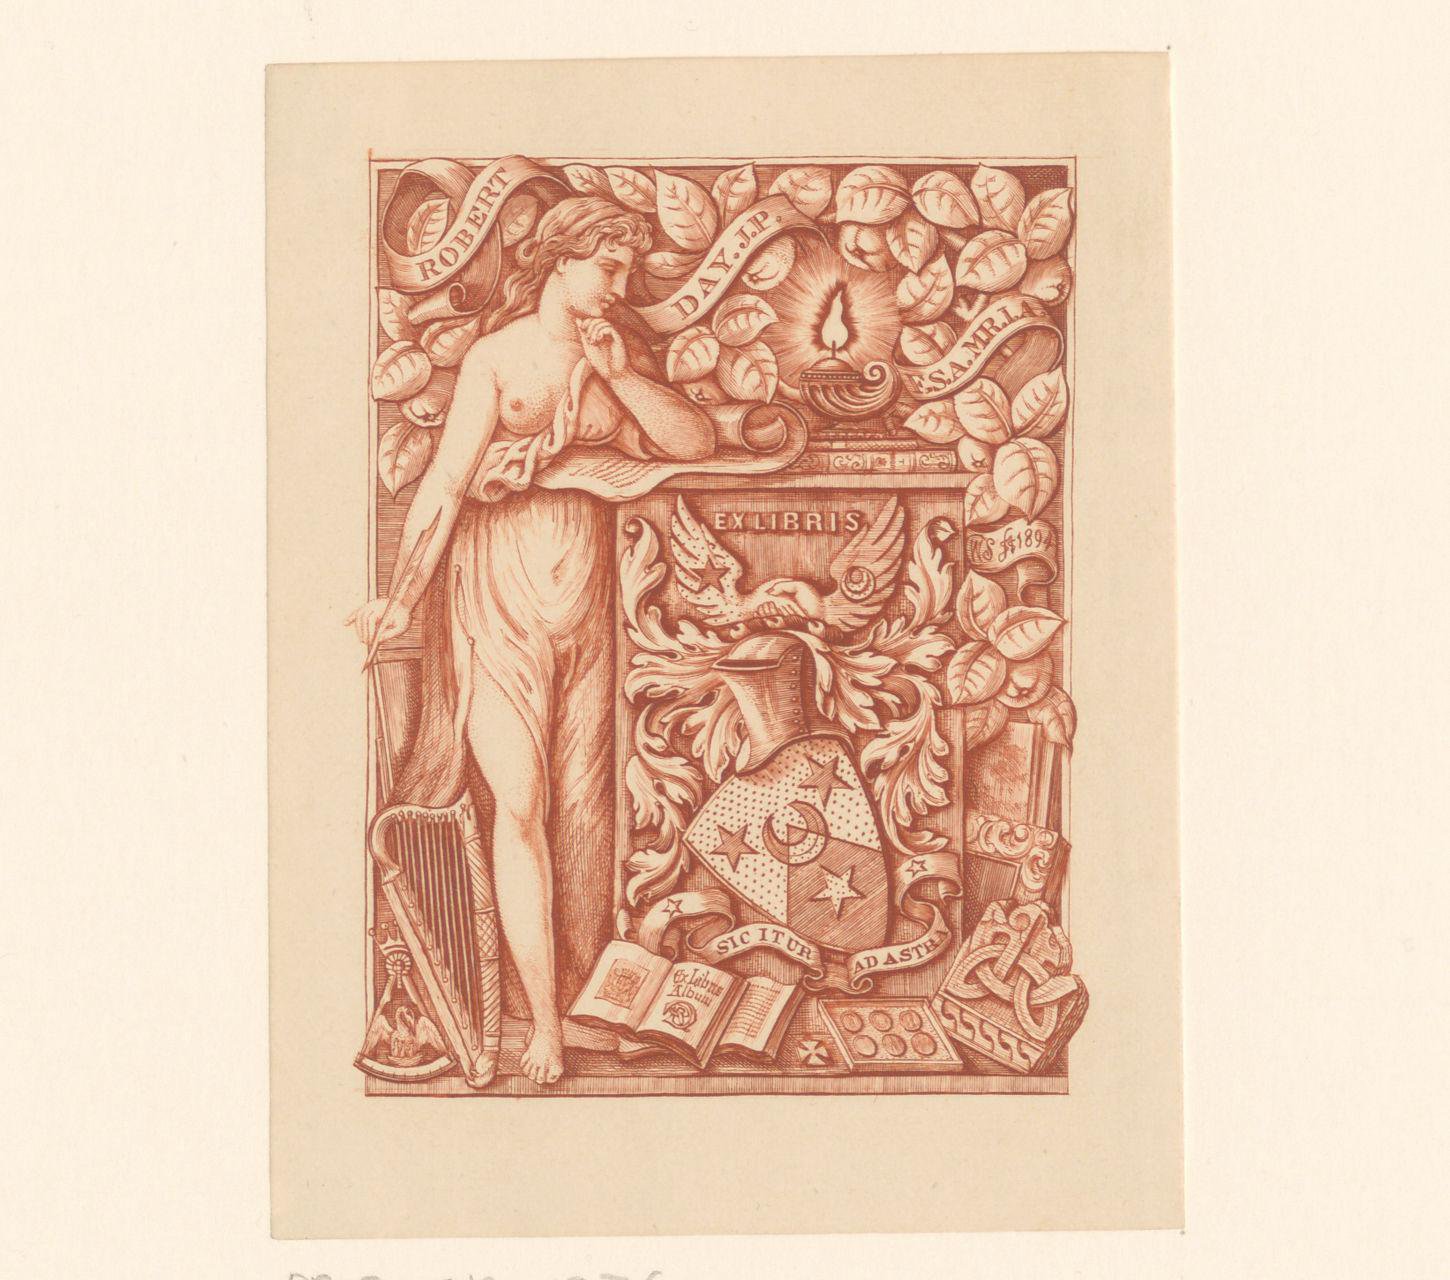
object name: bookplate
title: Ex libris van Robert Day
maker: charles william sherborn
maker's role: print maker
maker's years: 1831-1912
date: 1894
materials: paper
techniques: engraving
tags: robert day, the liberal arts, 'artes liberales', foliage ~ ornament, armorial bearing, heraldry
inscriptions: collector's mark: Lugt 2228